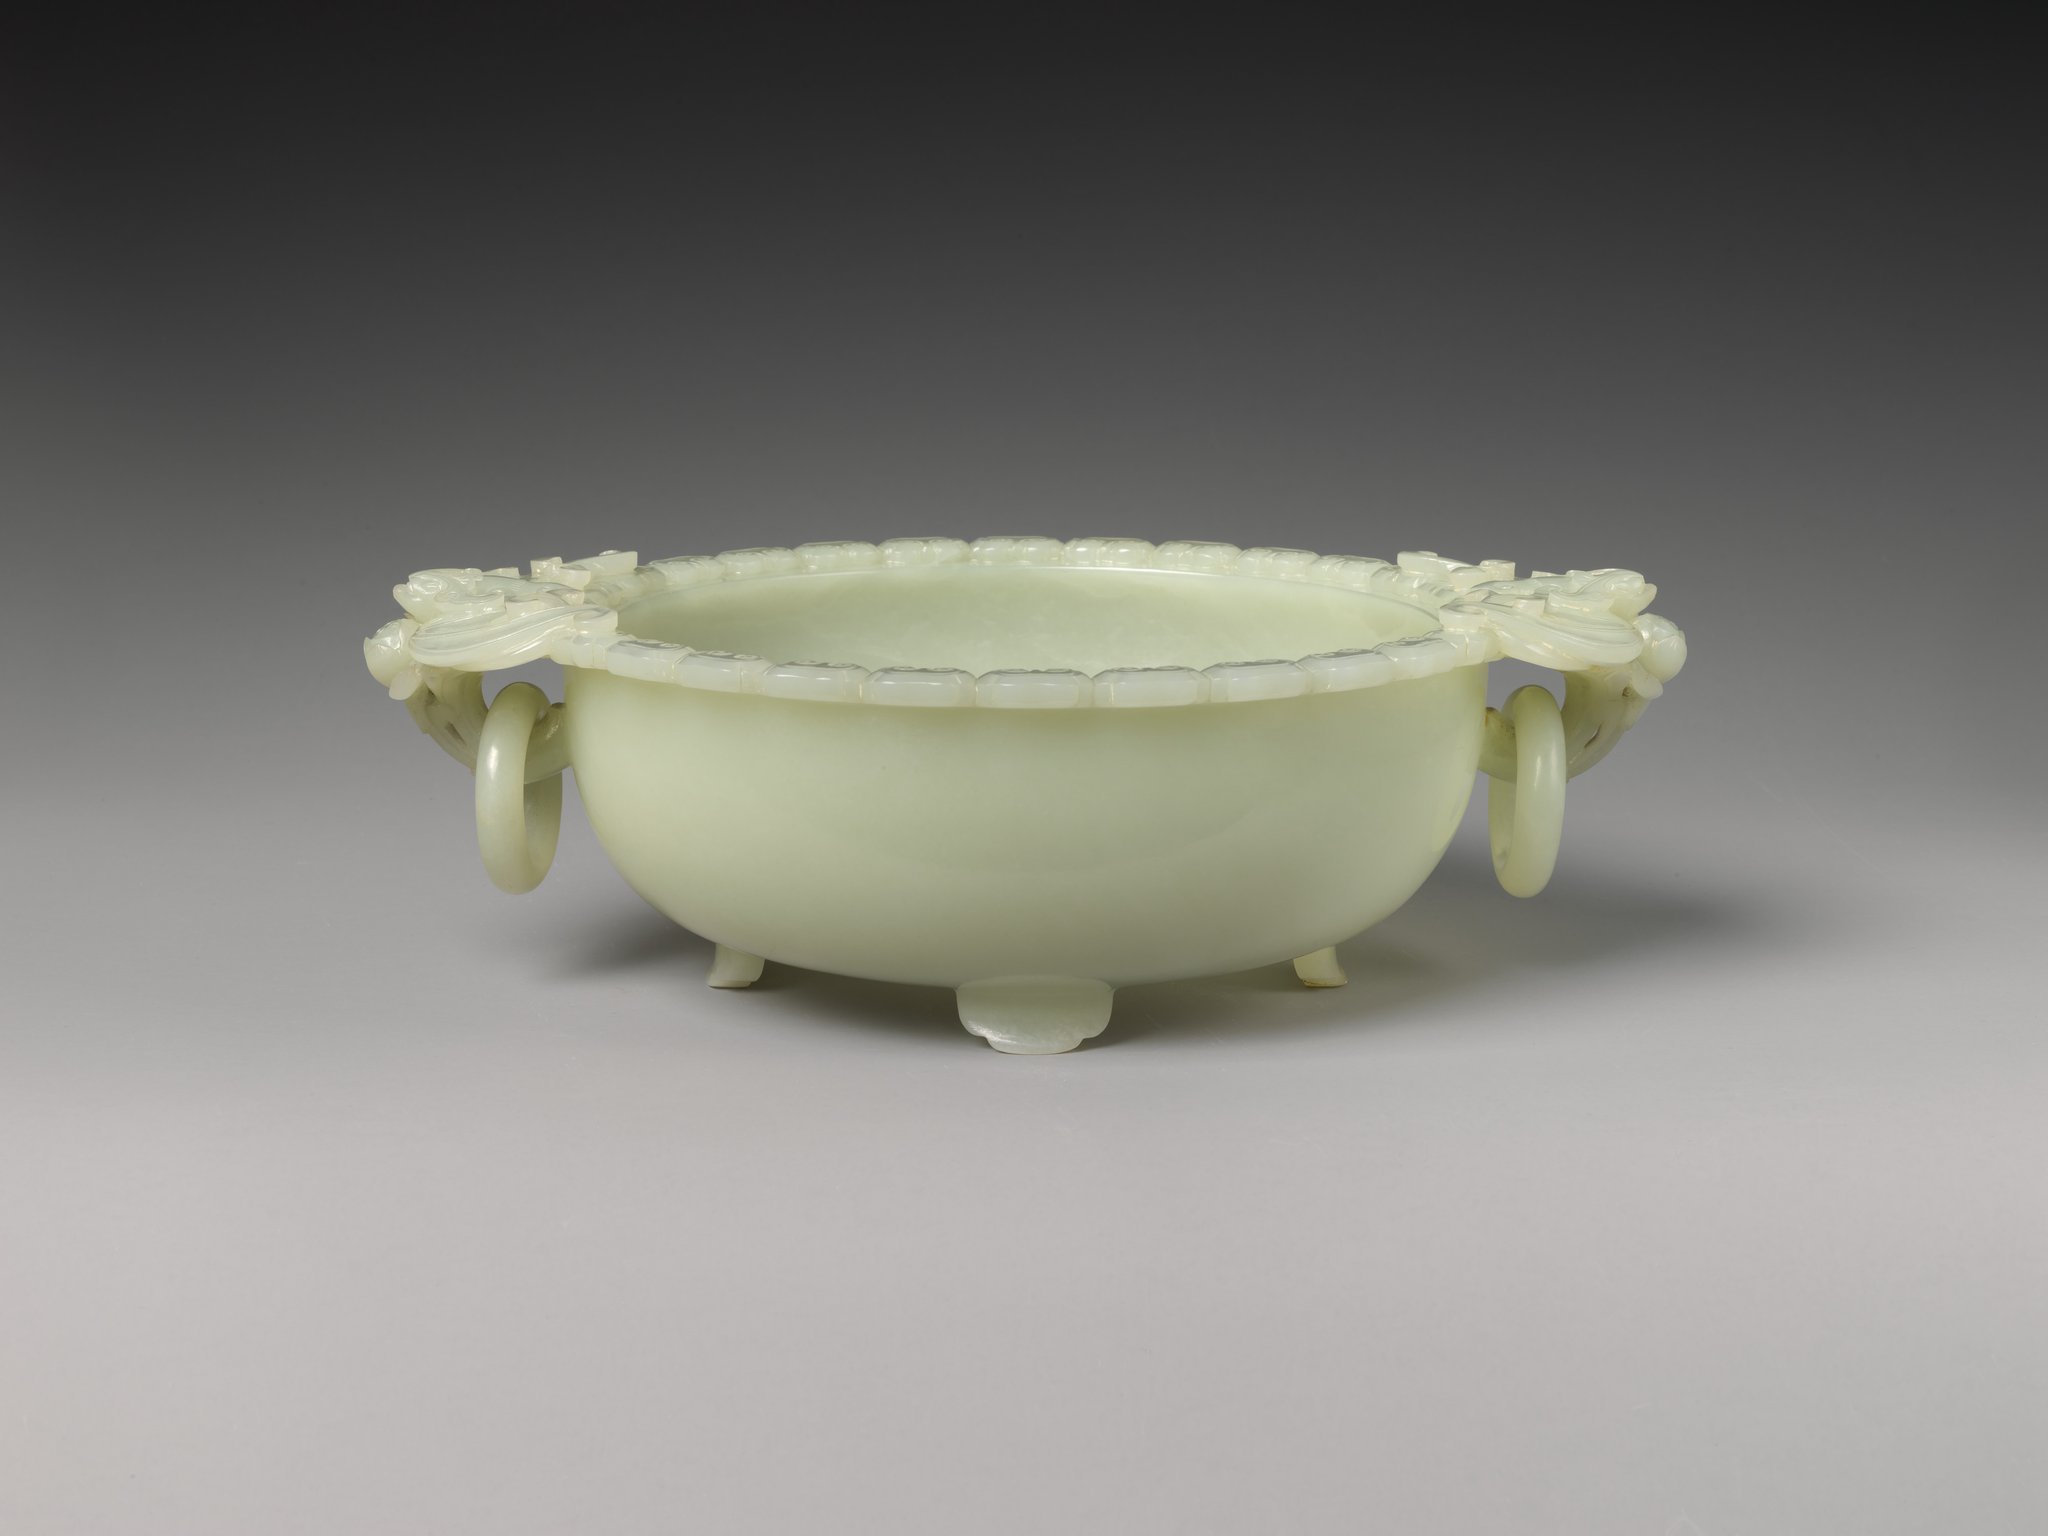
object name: handle of a bowl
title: Bowl with handles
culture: chinese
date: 1736-1795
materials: jade